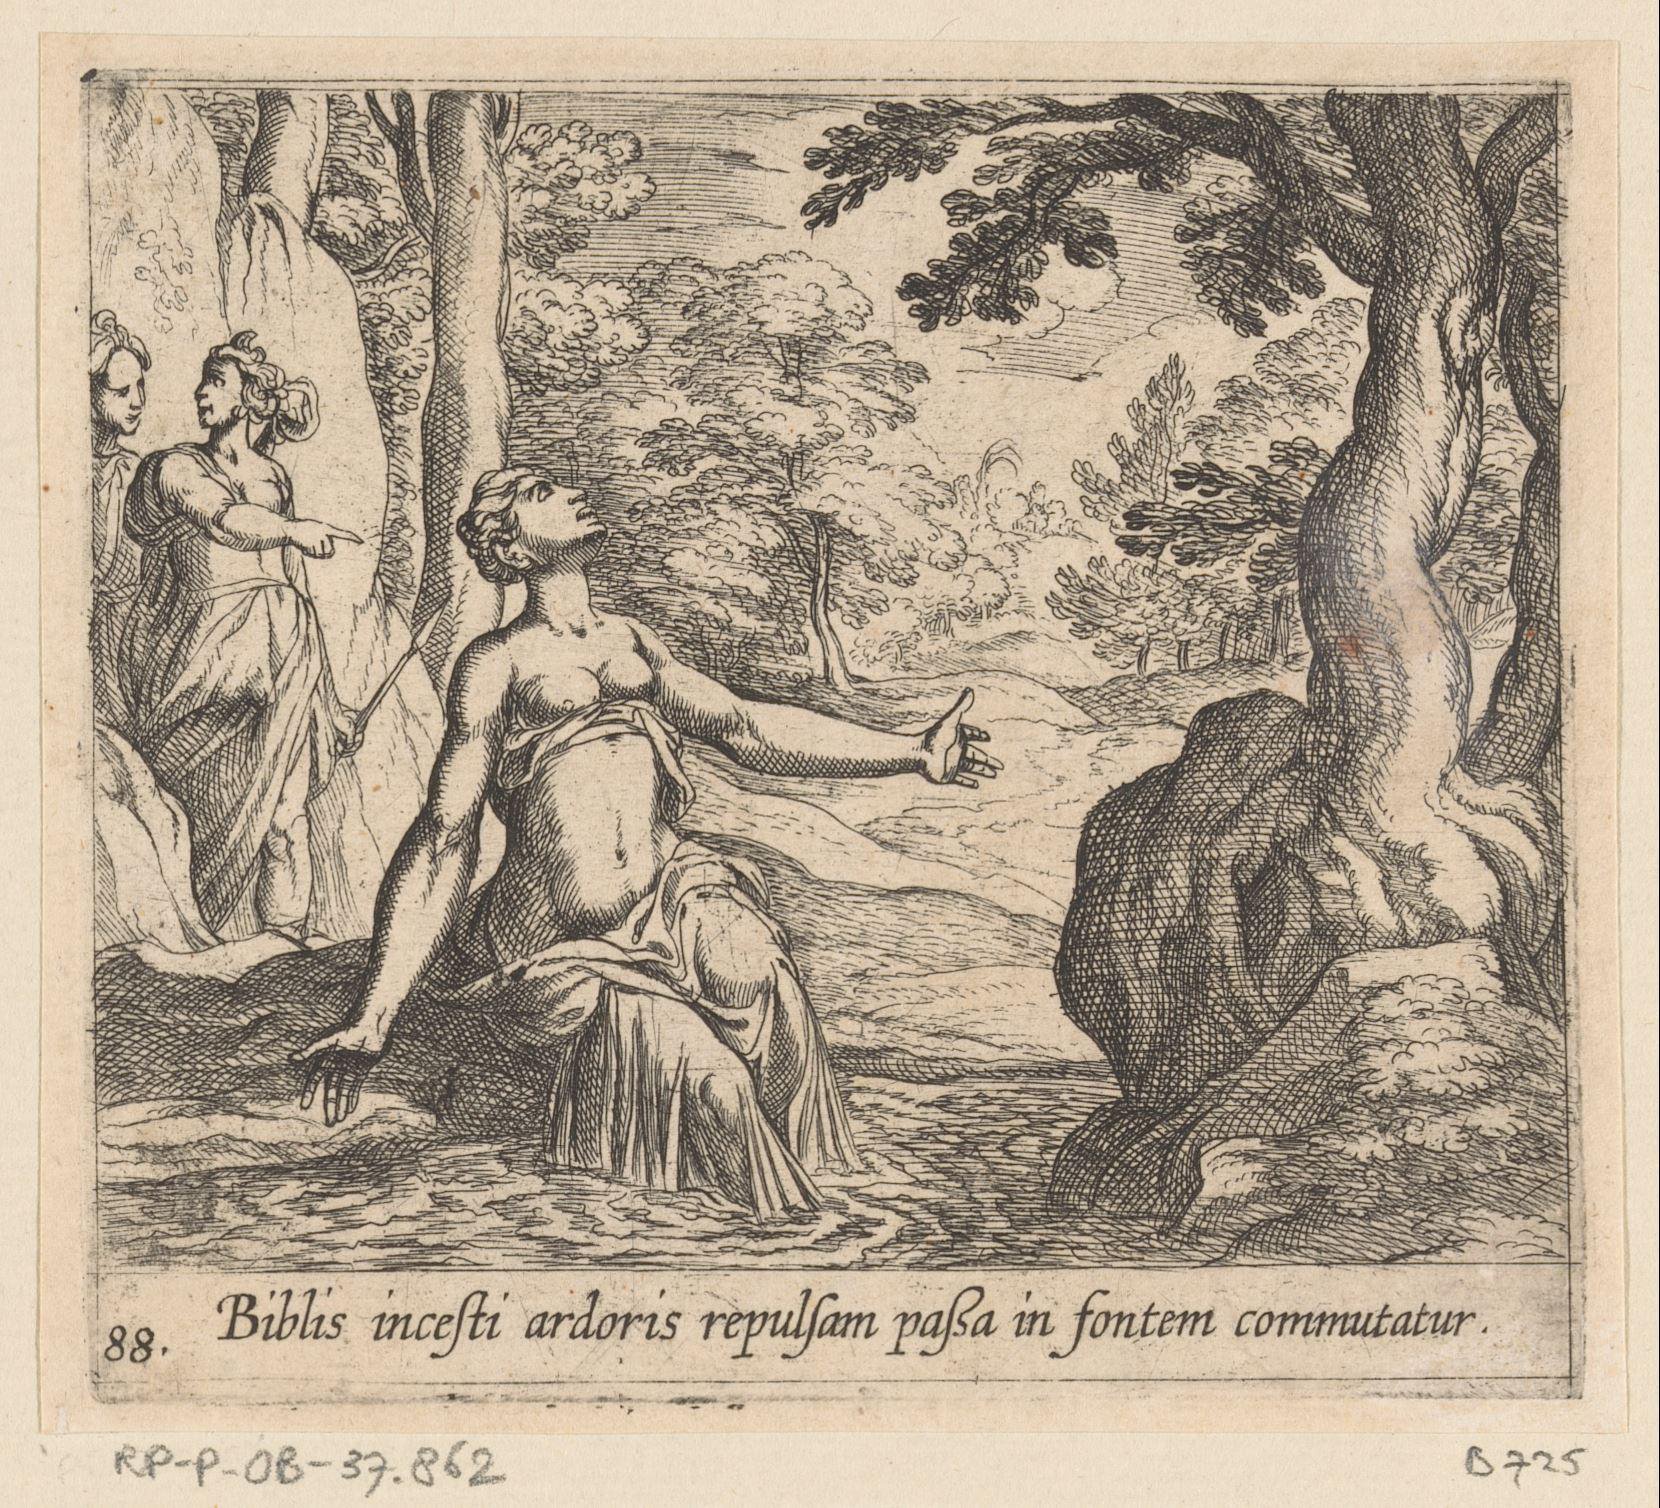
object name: print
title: Byblis in een beek veranderd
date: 1606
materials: paper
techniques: etching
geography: italy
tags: byblis changed into a fountain: after looking for caunus everywhere, byblis at last lies down, bathed in tears, and is changed into a fountain (ovid, metamorphoses ix 663)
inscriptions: collector's mark: Lugt 240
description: Byblis was verliefd op haar broer Caunus. Toen hij verdween en zij hem niet kon vinden baadde Byblis in tranen. Ze verandert in een beek. Titel in het Latijn in ondermarge.